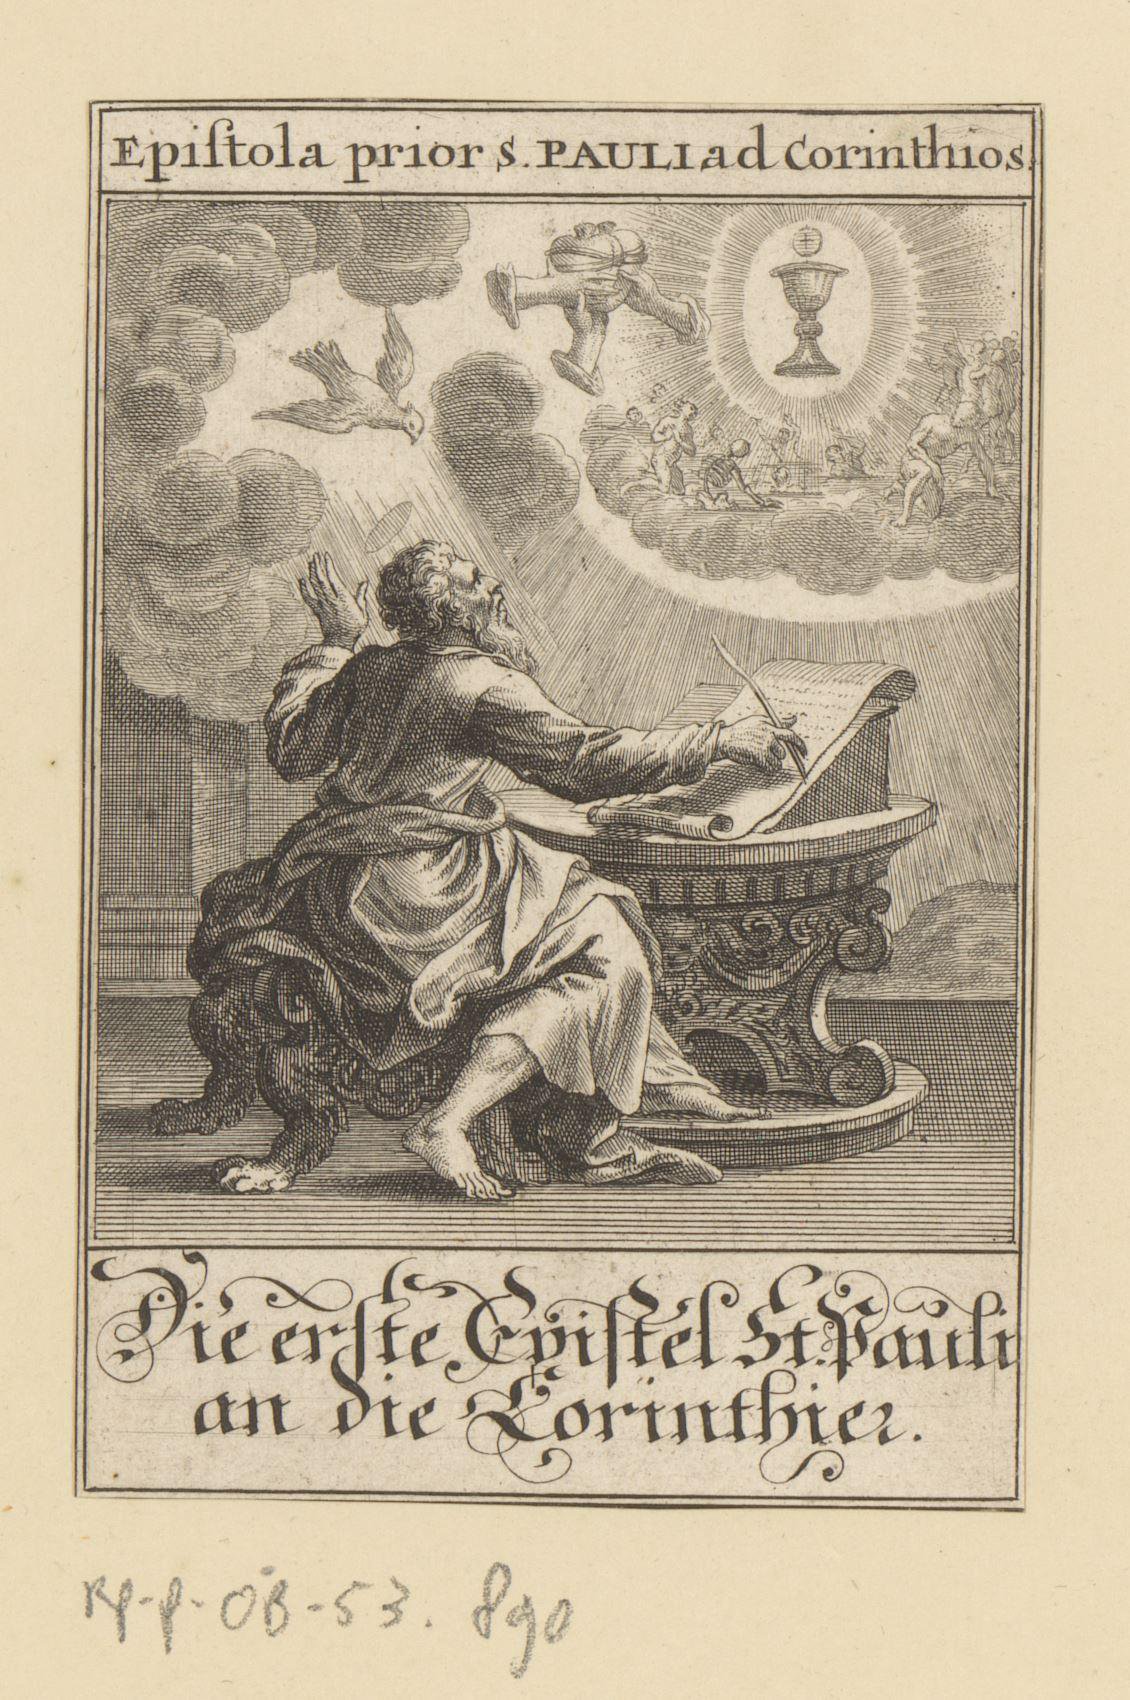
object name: print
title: Apostel Paulus schrijft zijn brief aan de Korinthiërs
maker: Anonymous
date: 1697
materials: paper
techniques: etching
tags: st. paul writing his epistles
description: Prent ook gebruikt in: Biblia ectypa : Bildnussen auss Heiliger Schrifft. Regensburg: Chr. Wiegel, 1697.